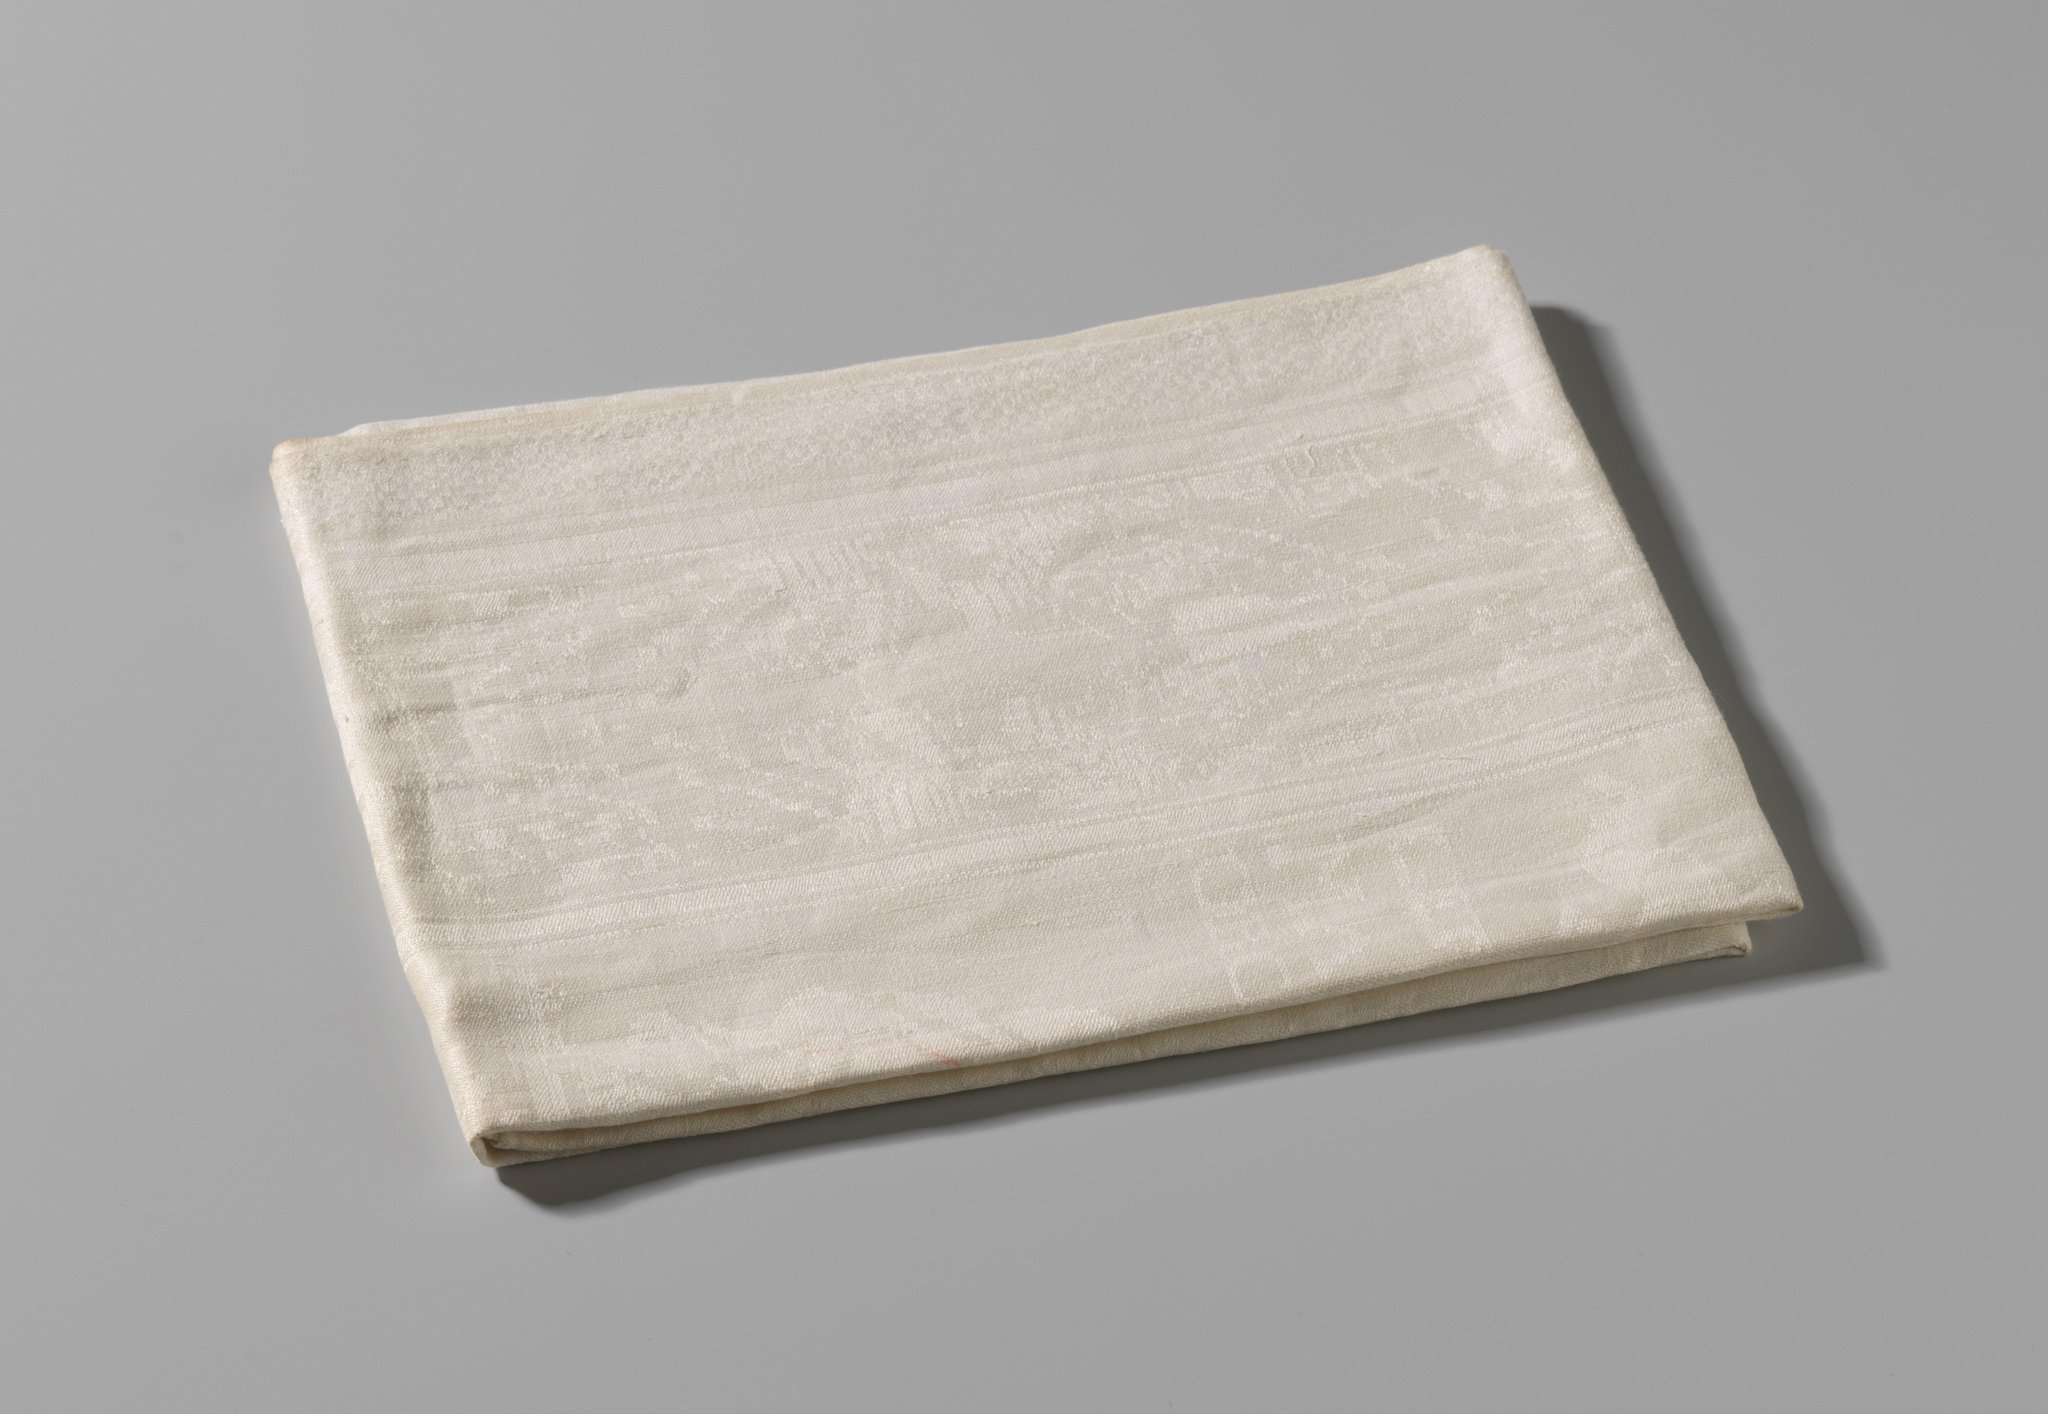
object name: napkin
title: Servet met de slag bij Malplaquet en het ruiterportret en wapen van John Churchill hertog van Marlborough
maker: Anonymous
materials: linen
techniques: damask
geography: kortrijk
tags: paris, vienna, eugenius van savoye, john churchill (1e hertog van marlborough)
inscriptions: mark: ‘12’, mark: ‘AEK’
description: Servet van linnendamast met de slag bij Malplaquet en het ruiterportret en wapen van John Churchill hertog van Marlborough. Ingeweven: GEN/ MARLB/ OROUG en MALPLAQUE.